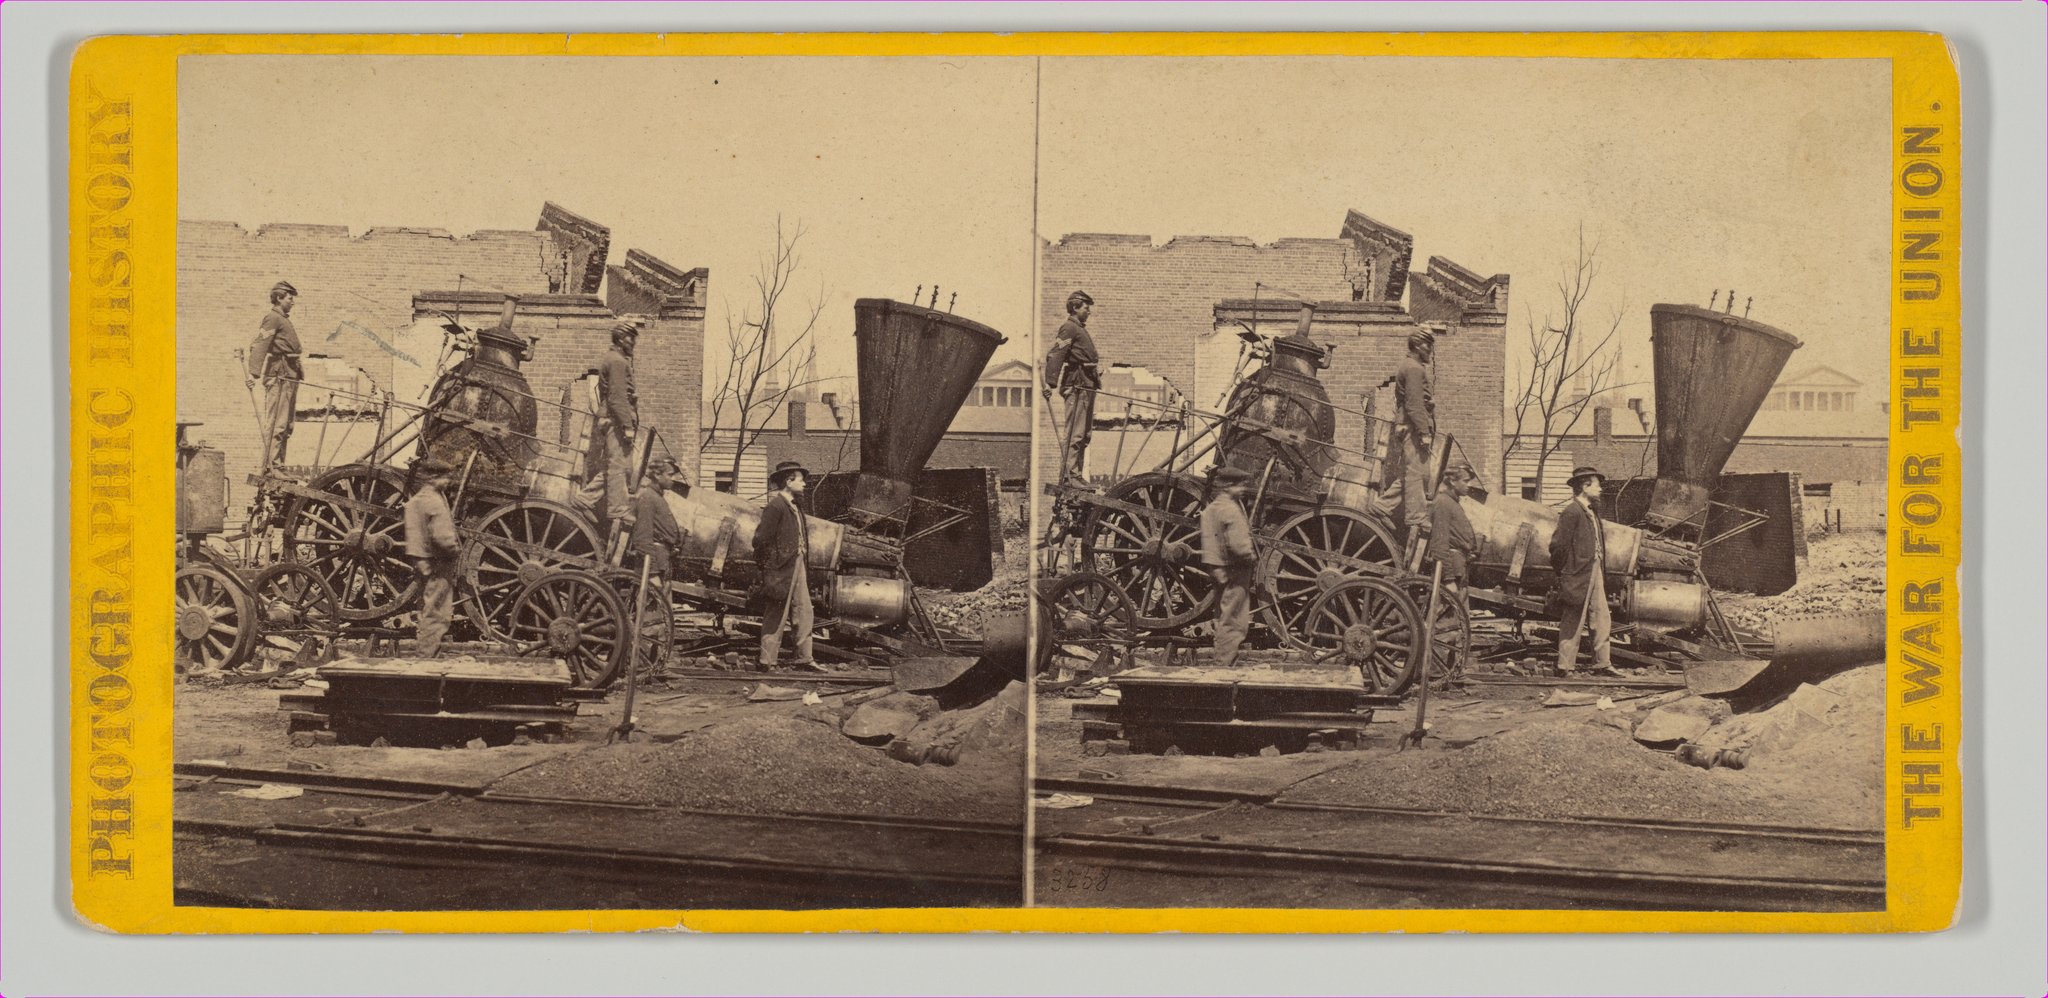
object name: stereograph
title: Ruins of a Locomotive in the Petersburgh Railroad Depot, Richmond, Virginia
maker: Anonymous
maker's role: artist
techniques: albumen silver print, glass negative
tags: american civil war